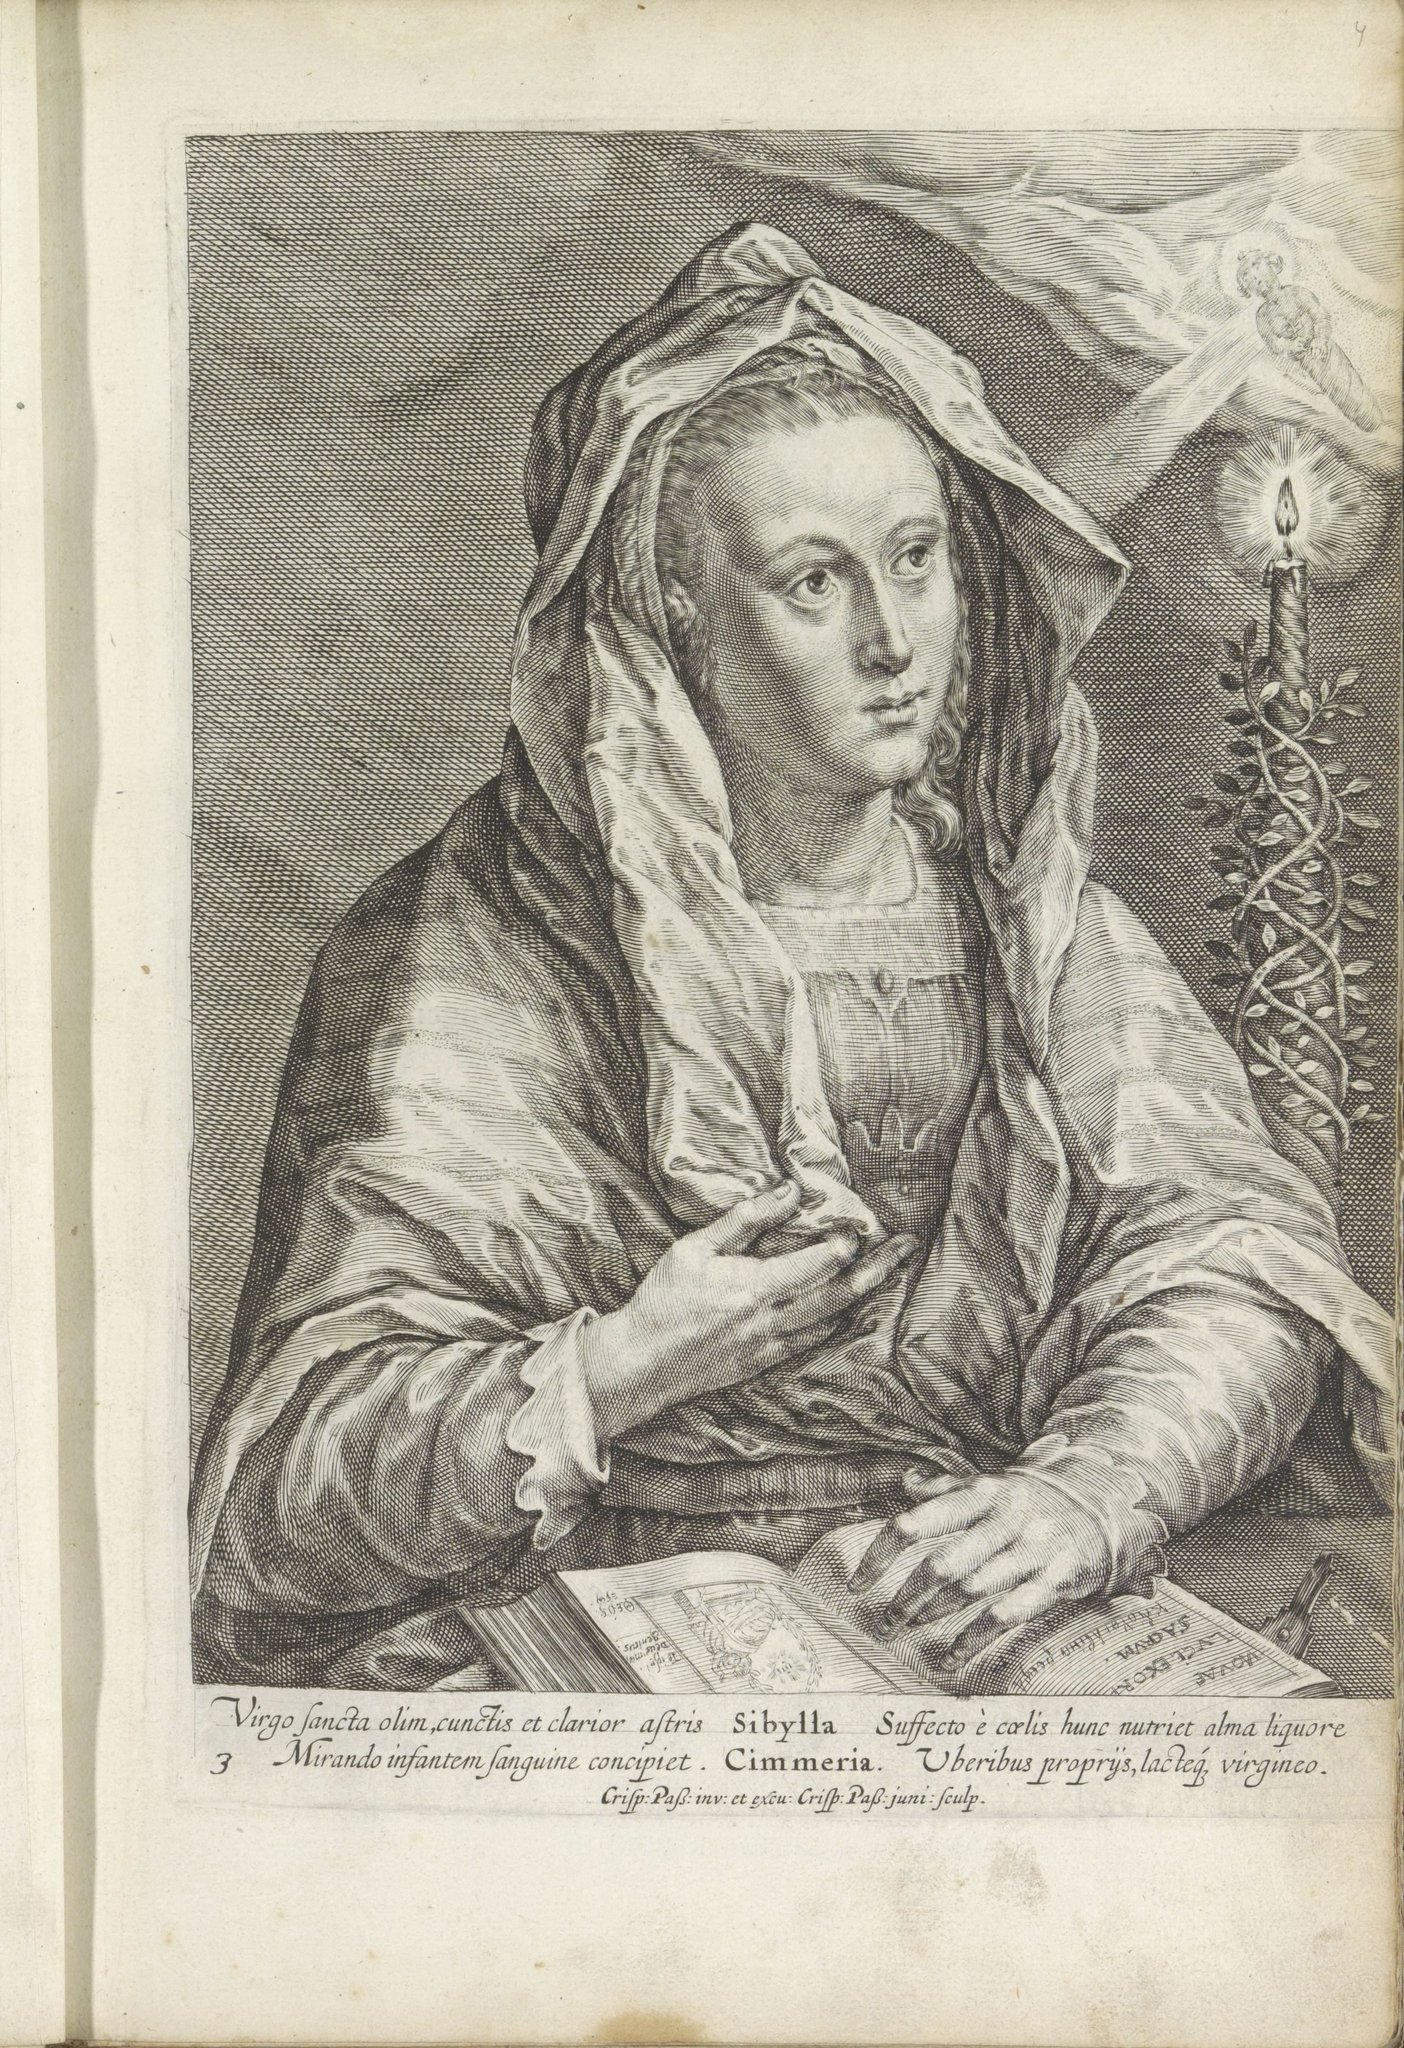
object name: album leaf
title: Sibylla Cimmeria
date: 1615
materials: paper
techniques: engraving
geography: utrecht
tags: sibyls (with name), christ-child (with attributes)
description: De Cimmerische Sibille zit aan een tafel waarop een opengeslagen boek ligt. Ze kijkt naar de hemel waar het Christuskind verschijnt. Onder de voorstelling een onderschrift in het Latijn. Deze prent maakt deel uit van een album.